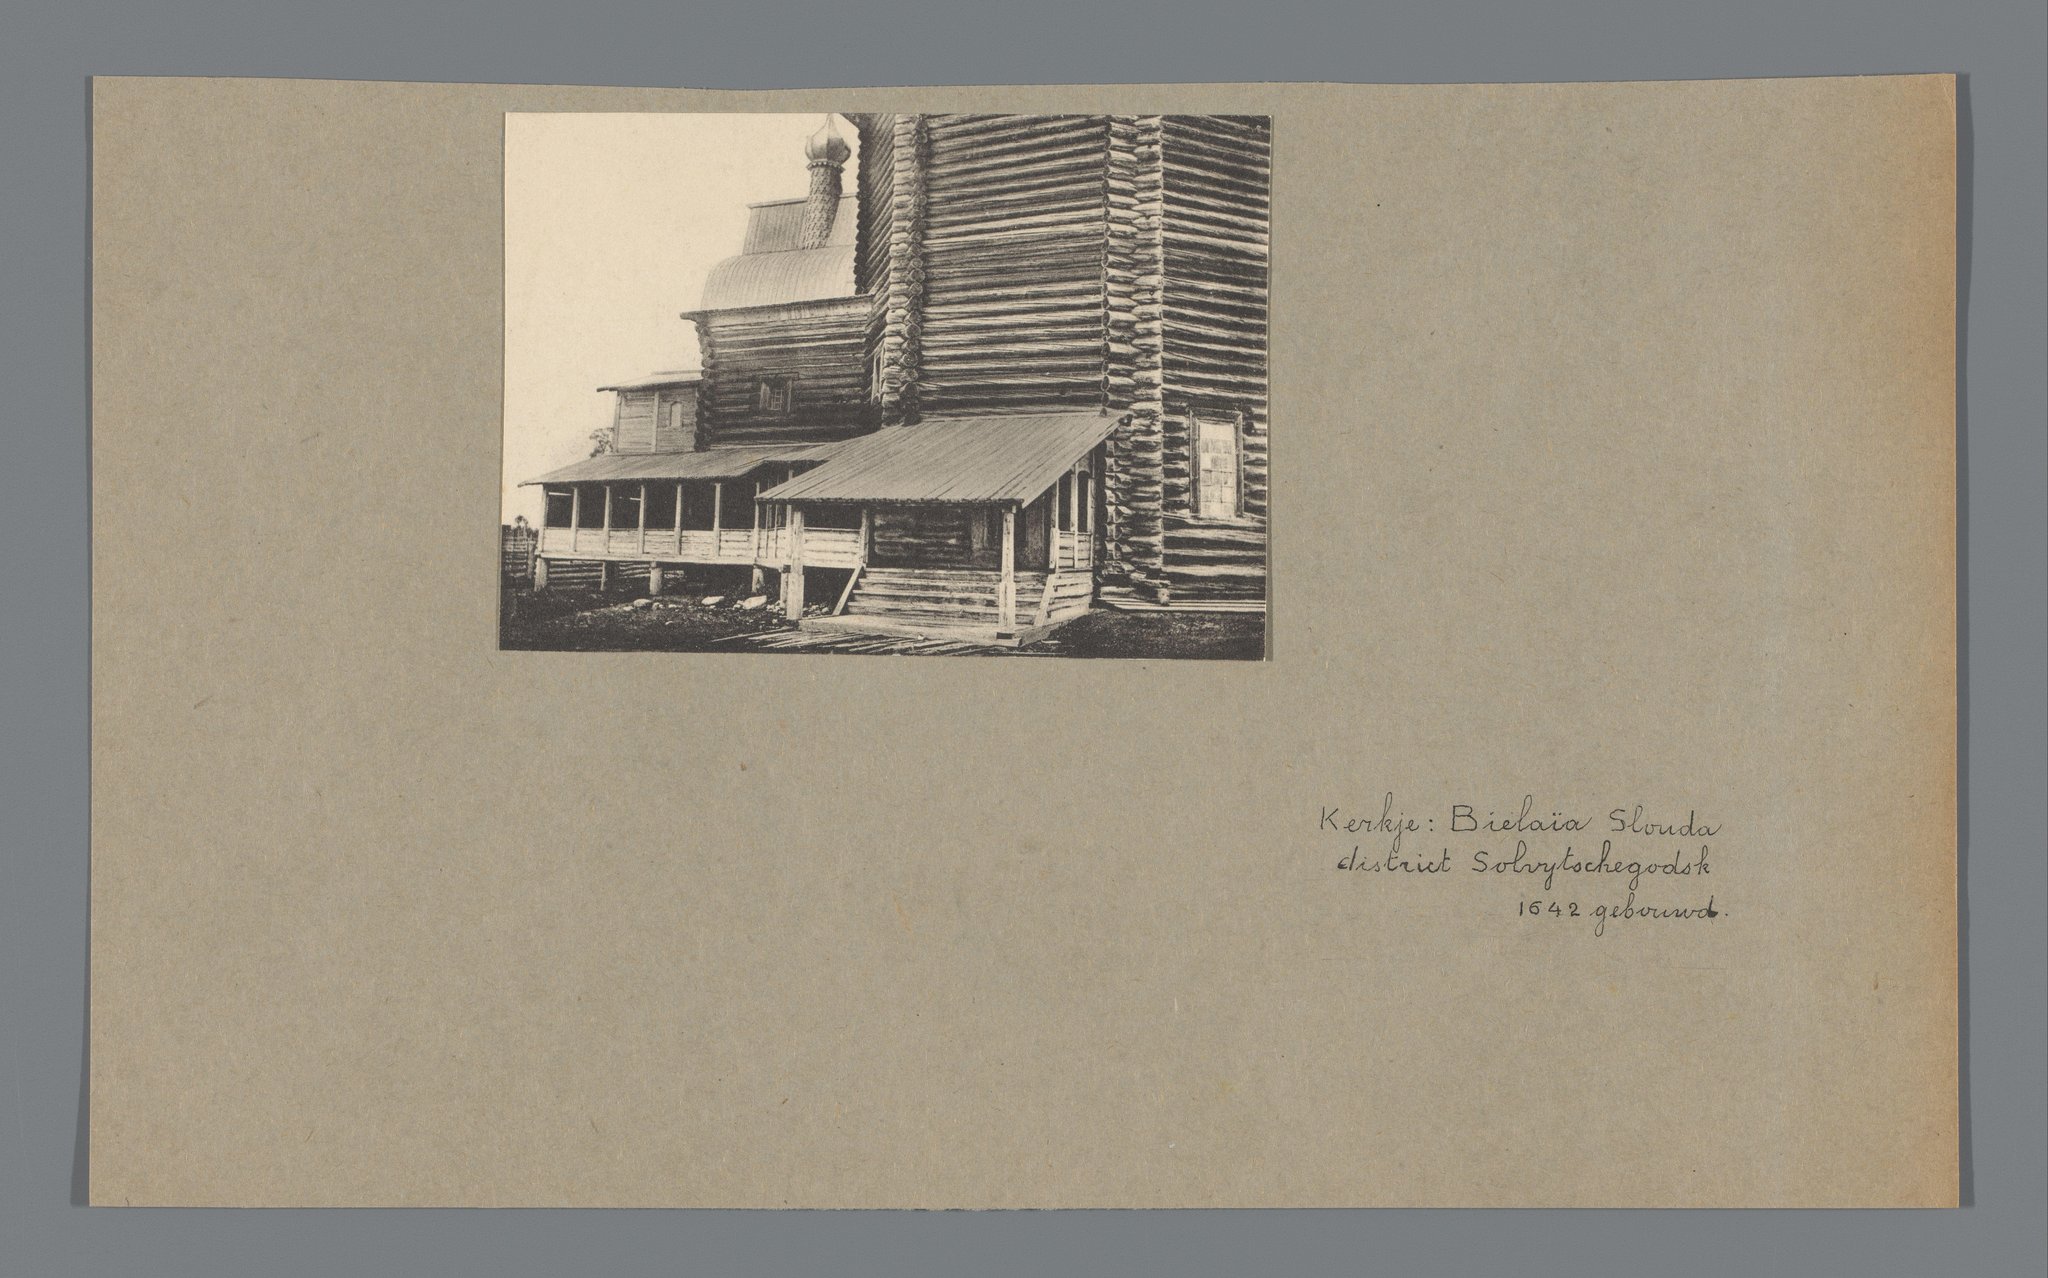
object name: photograph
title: Kerkje: Bielaïa Slouda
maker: Anonymous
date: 1860-1925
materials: photographic support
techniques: photograph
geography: russia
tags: russia